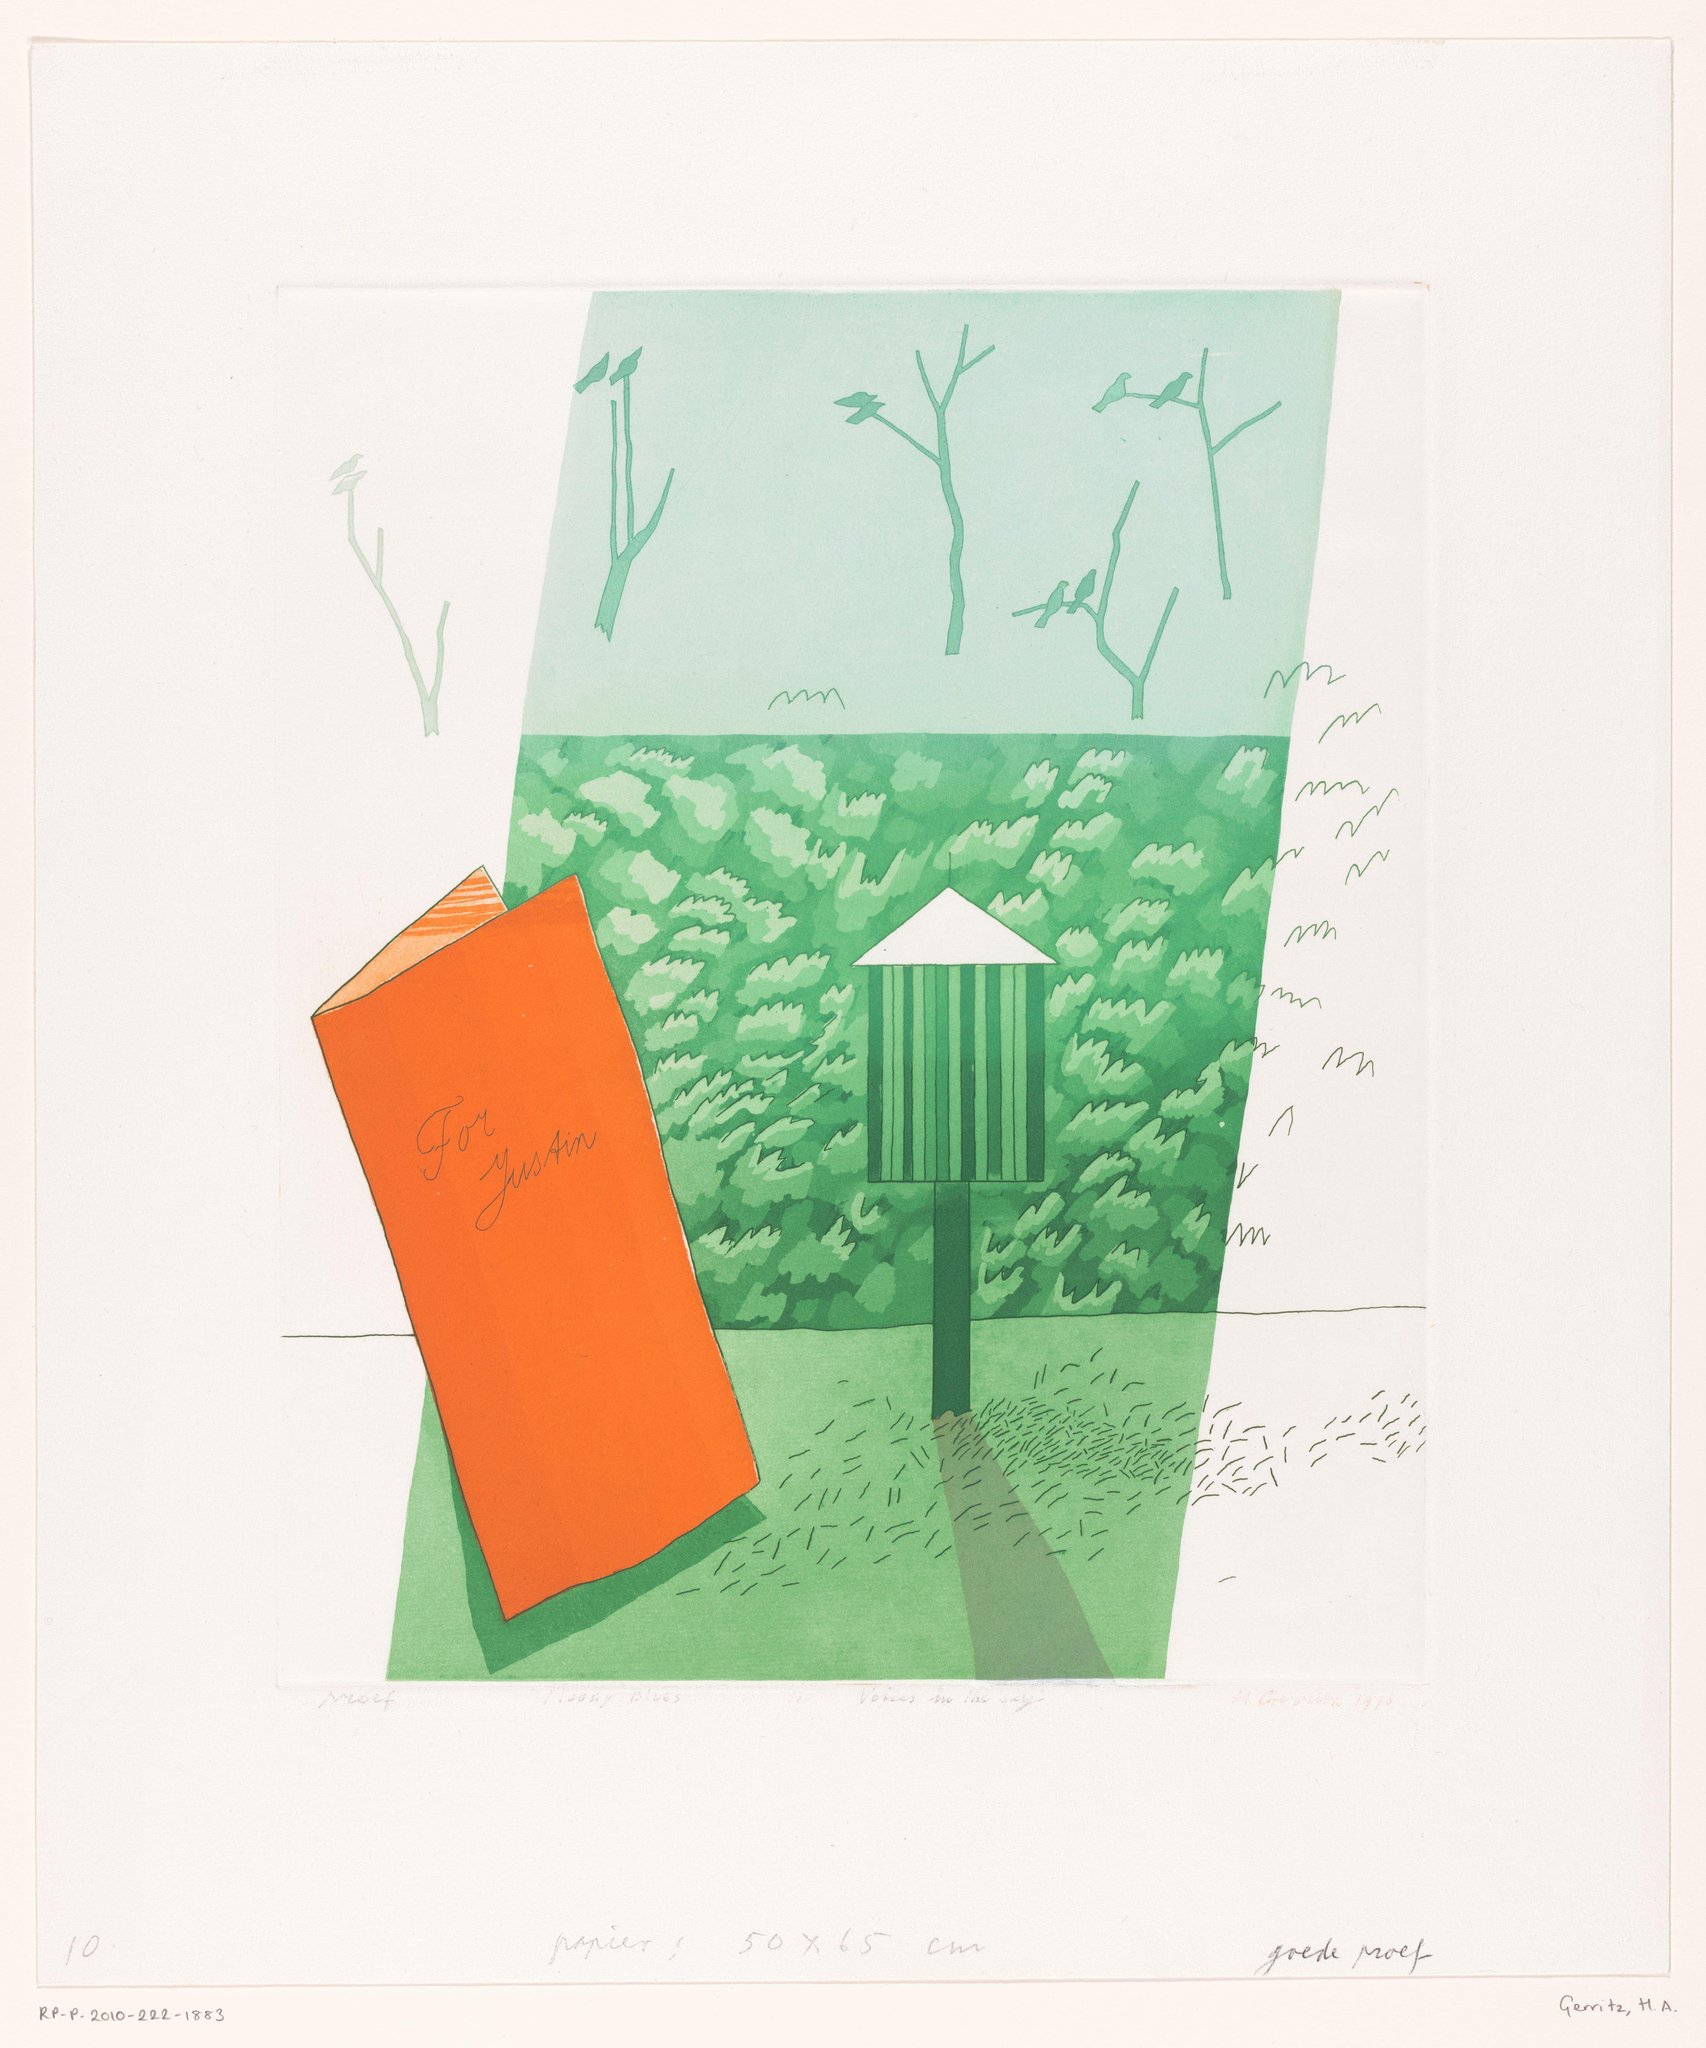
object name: print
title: Bloody Blues, Voices in the Sky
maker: harrie a. gerritz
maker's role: draughtsman, painter, print maker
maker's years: 1940-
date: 1978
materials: paper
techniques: aquatint, etching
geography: amsterdam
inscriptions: inscription: ‘proef’, signature and date: ‘H. Gerritz 1978’, title: ‘Moody Blues Voices in the sky’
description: Op de voorgrond een oranje dubbelgevouwen blad met daarop de tekst 'For Justin', op de achtergrond een tuin met een vogelhuis of duiventil.